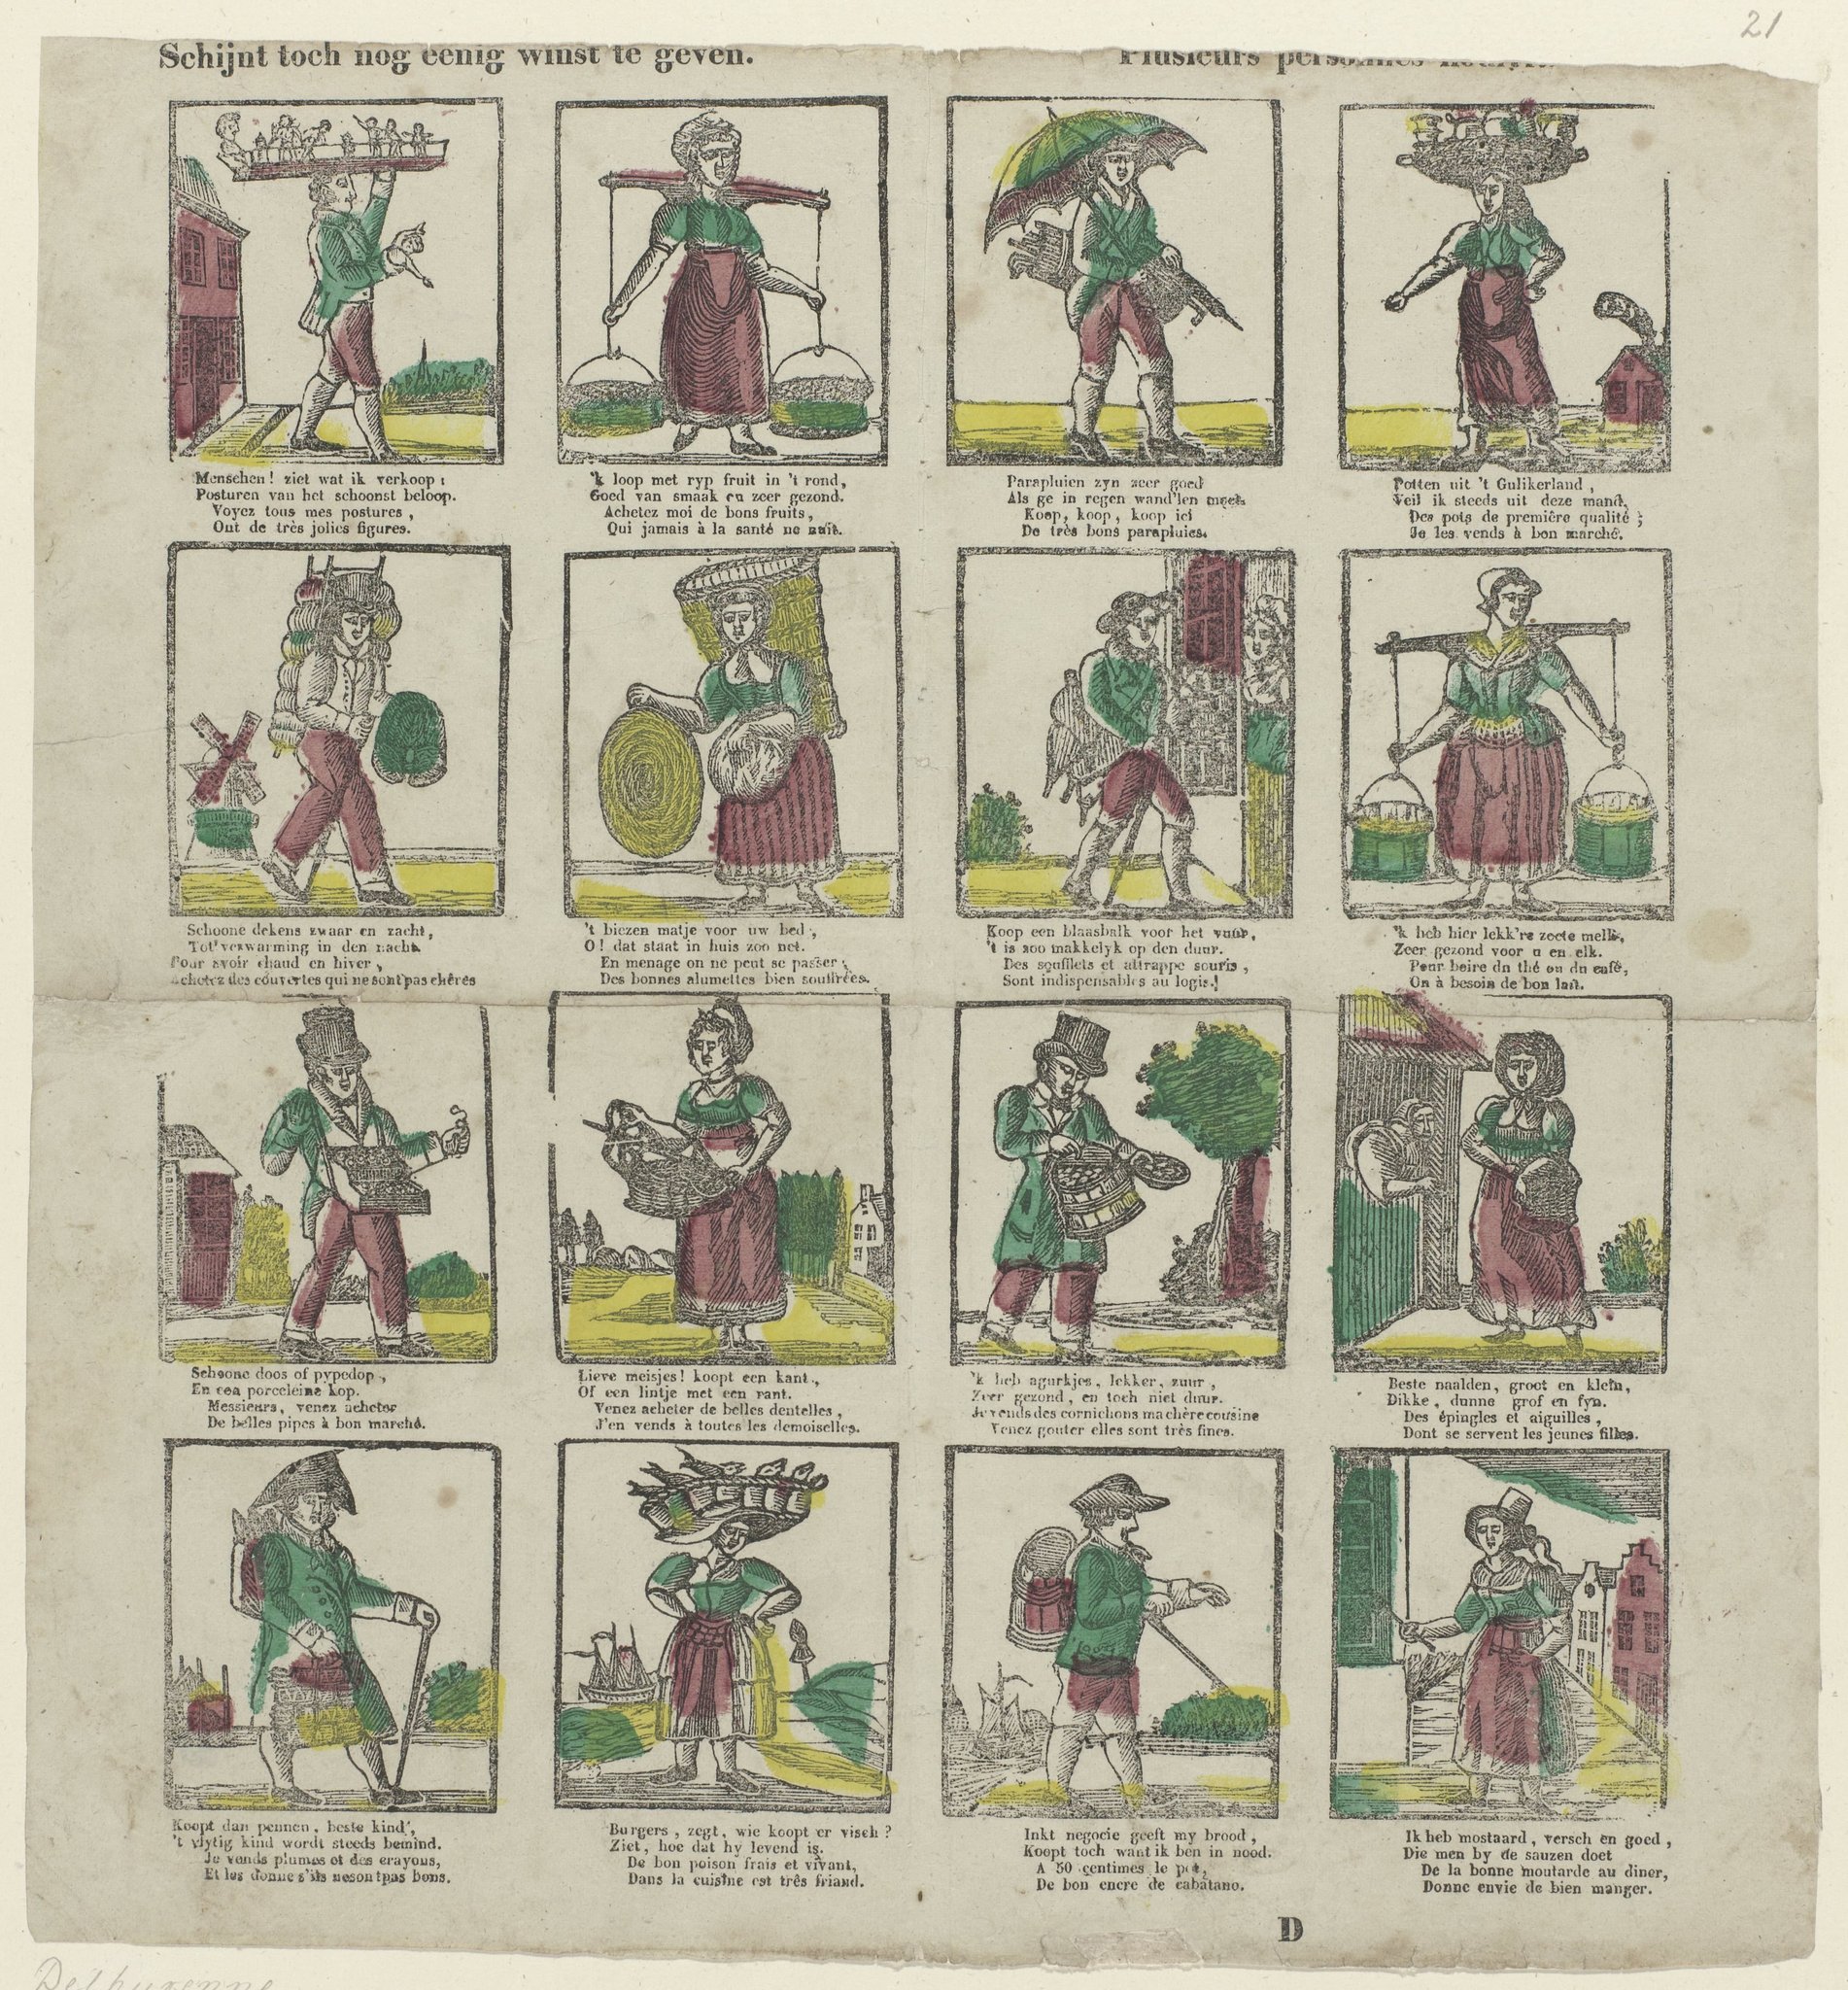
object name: print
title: Den handel, schoon in 't kleyn gedreven, / Schynt toch nog eenig winst te geven, / le commerce en petit, / Plusiers personnes nourrit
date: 1842-1856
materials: paper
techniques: colour, letterpress printing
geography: turnhout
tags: street-trader, merchant, salesman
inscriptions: collector's mark: Lugt 2760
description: Blad met 16 voorstellingen van straatverkopers, zoals een fruitverkoopster, een dekenverkoper en een visverkooptster. Onder elke voorstelling een tweeregelig vers in het Nederlands en het Frans.